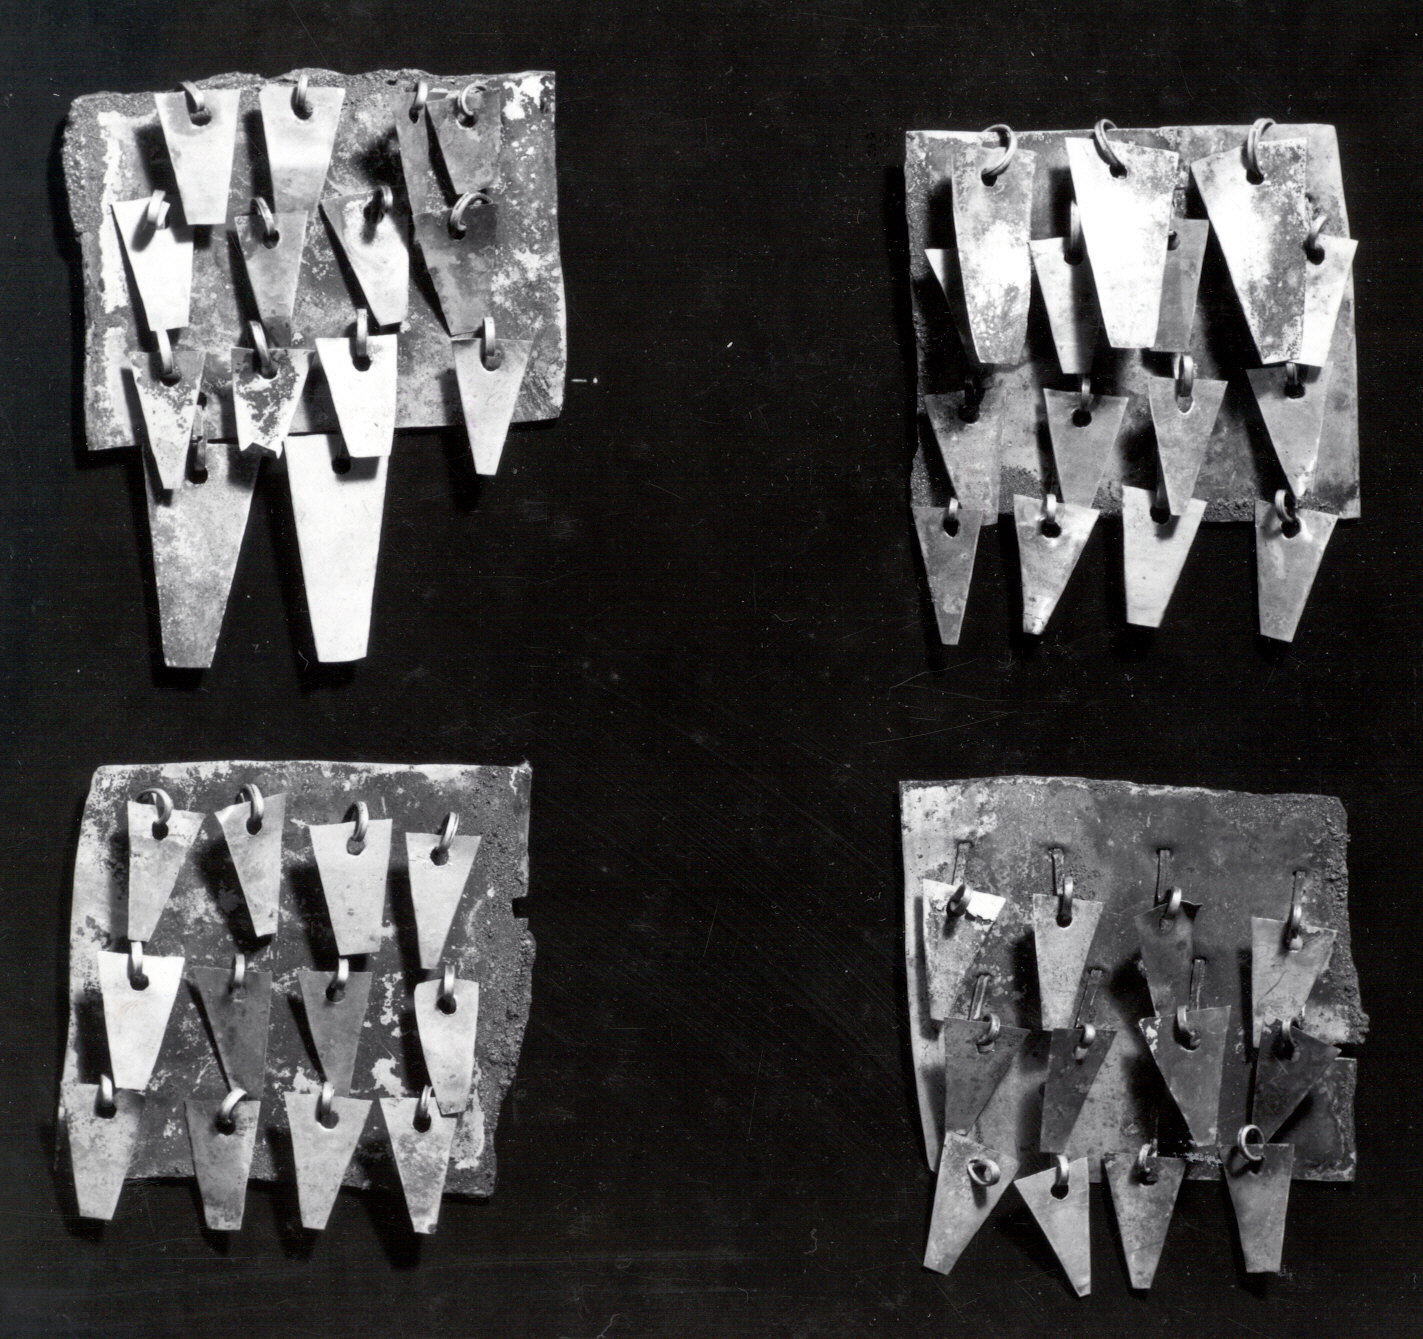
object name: ornament fragment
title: Gold Fragments with Dangles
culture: moche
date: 100 BCE-700 CE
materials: gold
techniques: hammering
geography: peru